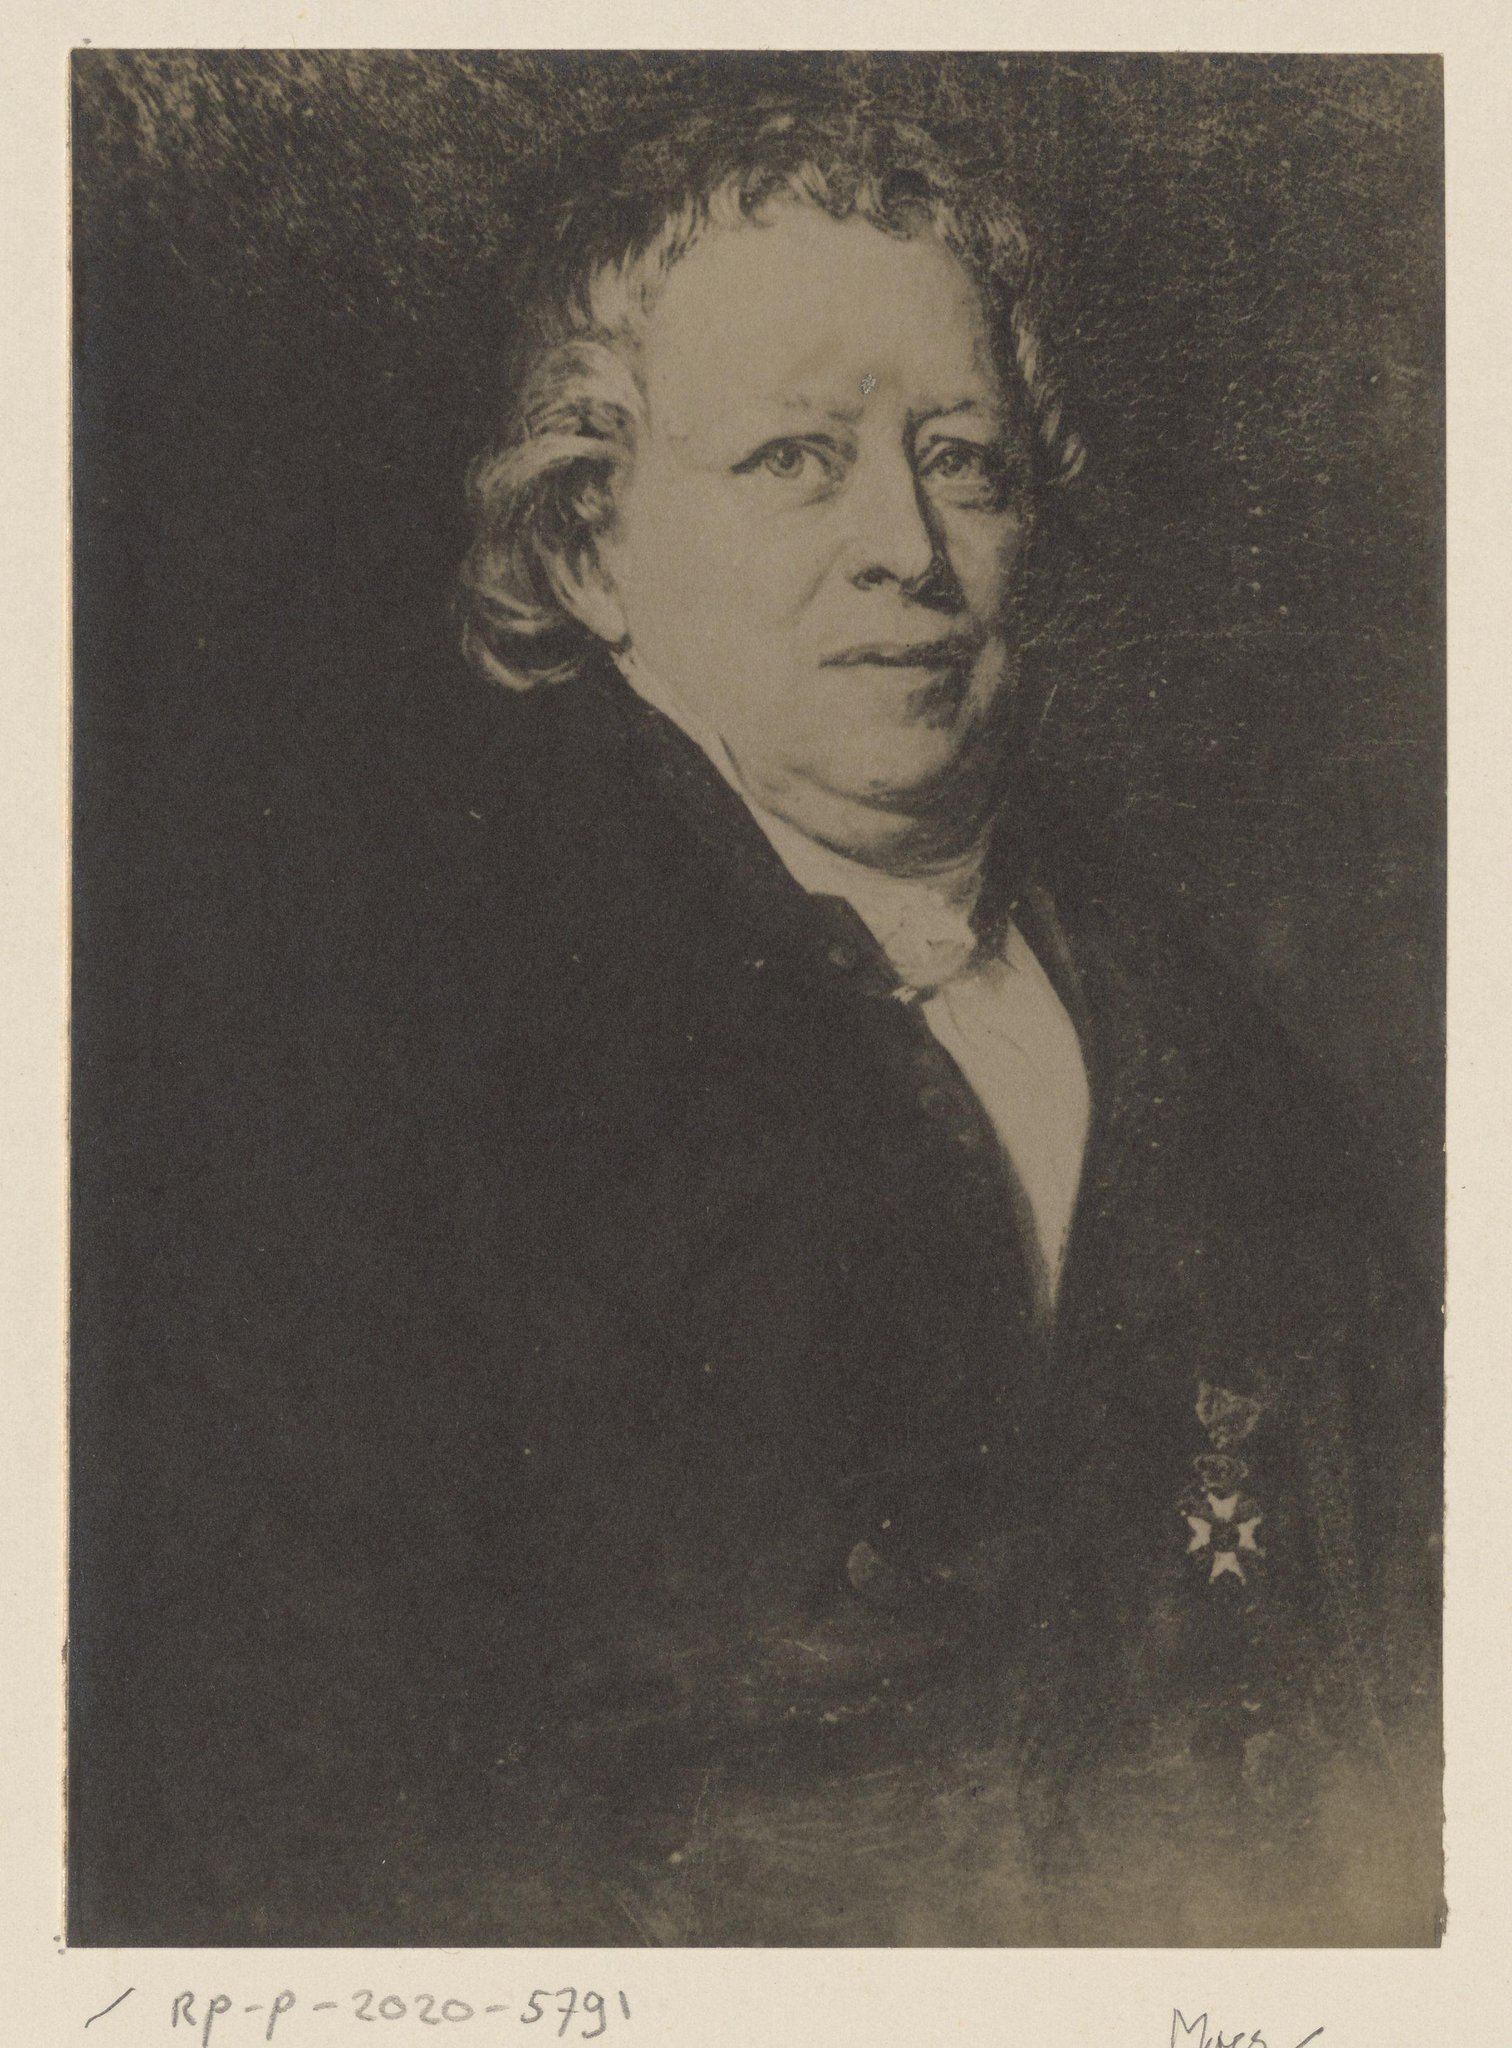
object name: reproduction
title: Portret van Ahasuerus Francken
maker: Anonymous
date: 1900-1936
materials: paper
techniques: gelatin silver print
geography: netherlands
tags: nijmegen, historical persons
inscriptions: inscription: ‘Dr. Ahasueros Franken/ geb. 1790 te Nijmegen/ gest. 1857 te Doorn./ Was achtereenvolgens predikant te/ Muiden, Doetinchem, Delft en Utrecht/ en werd in 1844 voorzitter van de/ Algem. Synode der Ned. Herv. Kerk./ Geschonken aan het Archief van Het Prov. Utr. Genootschap/ door zijn kleinzoon./ Dr. C.J. Wijnaends Francken’